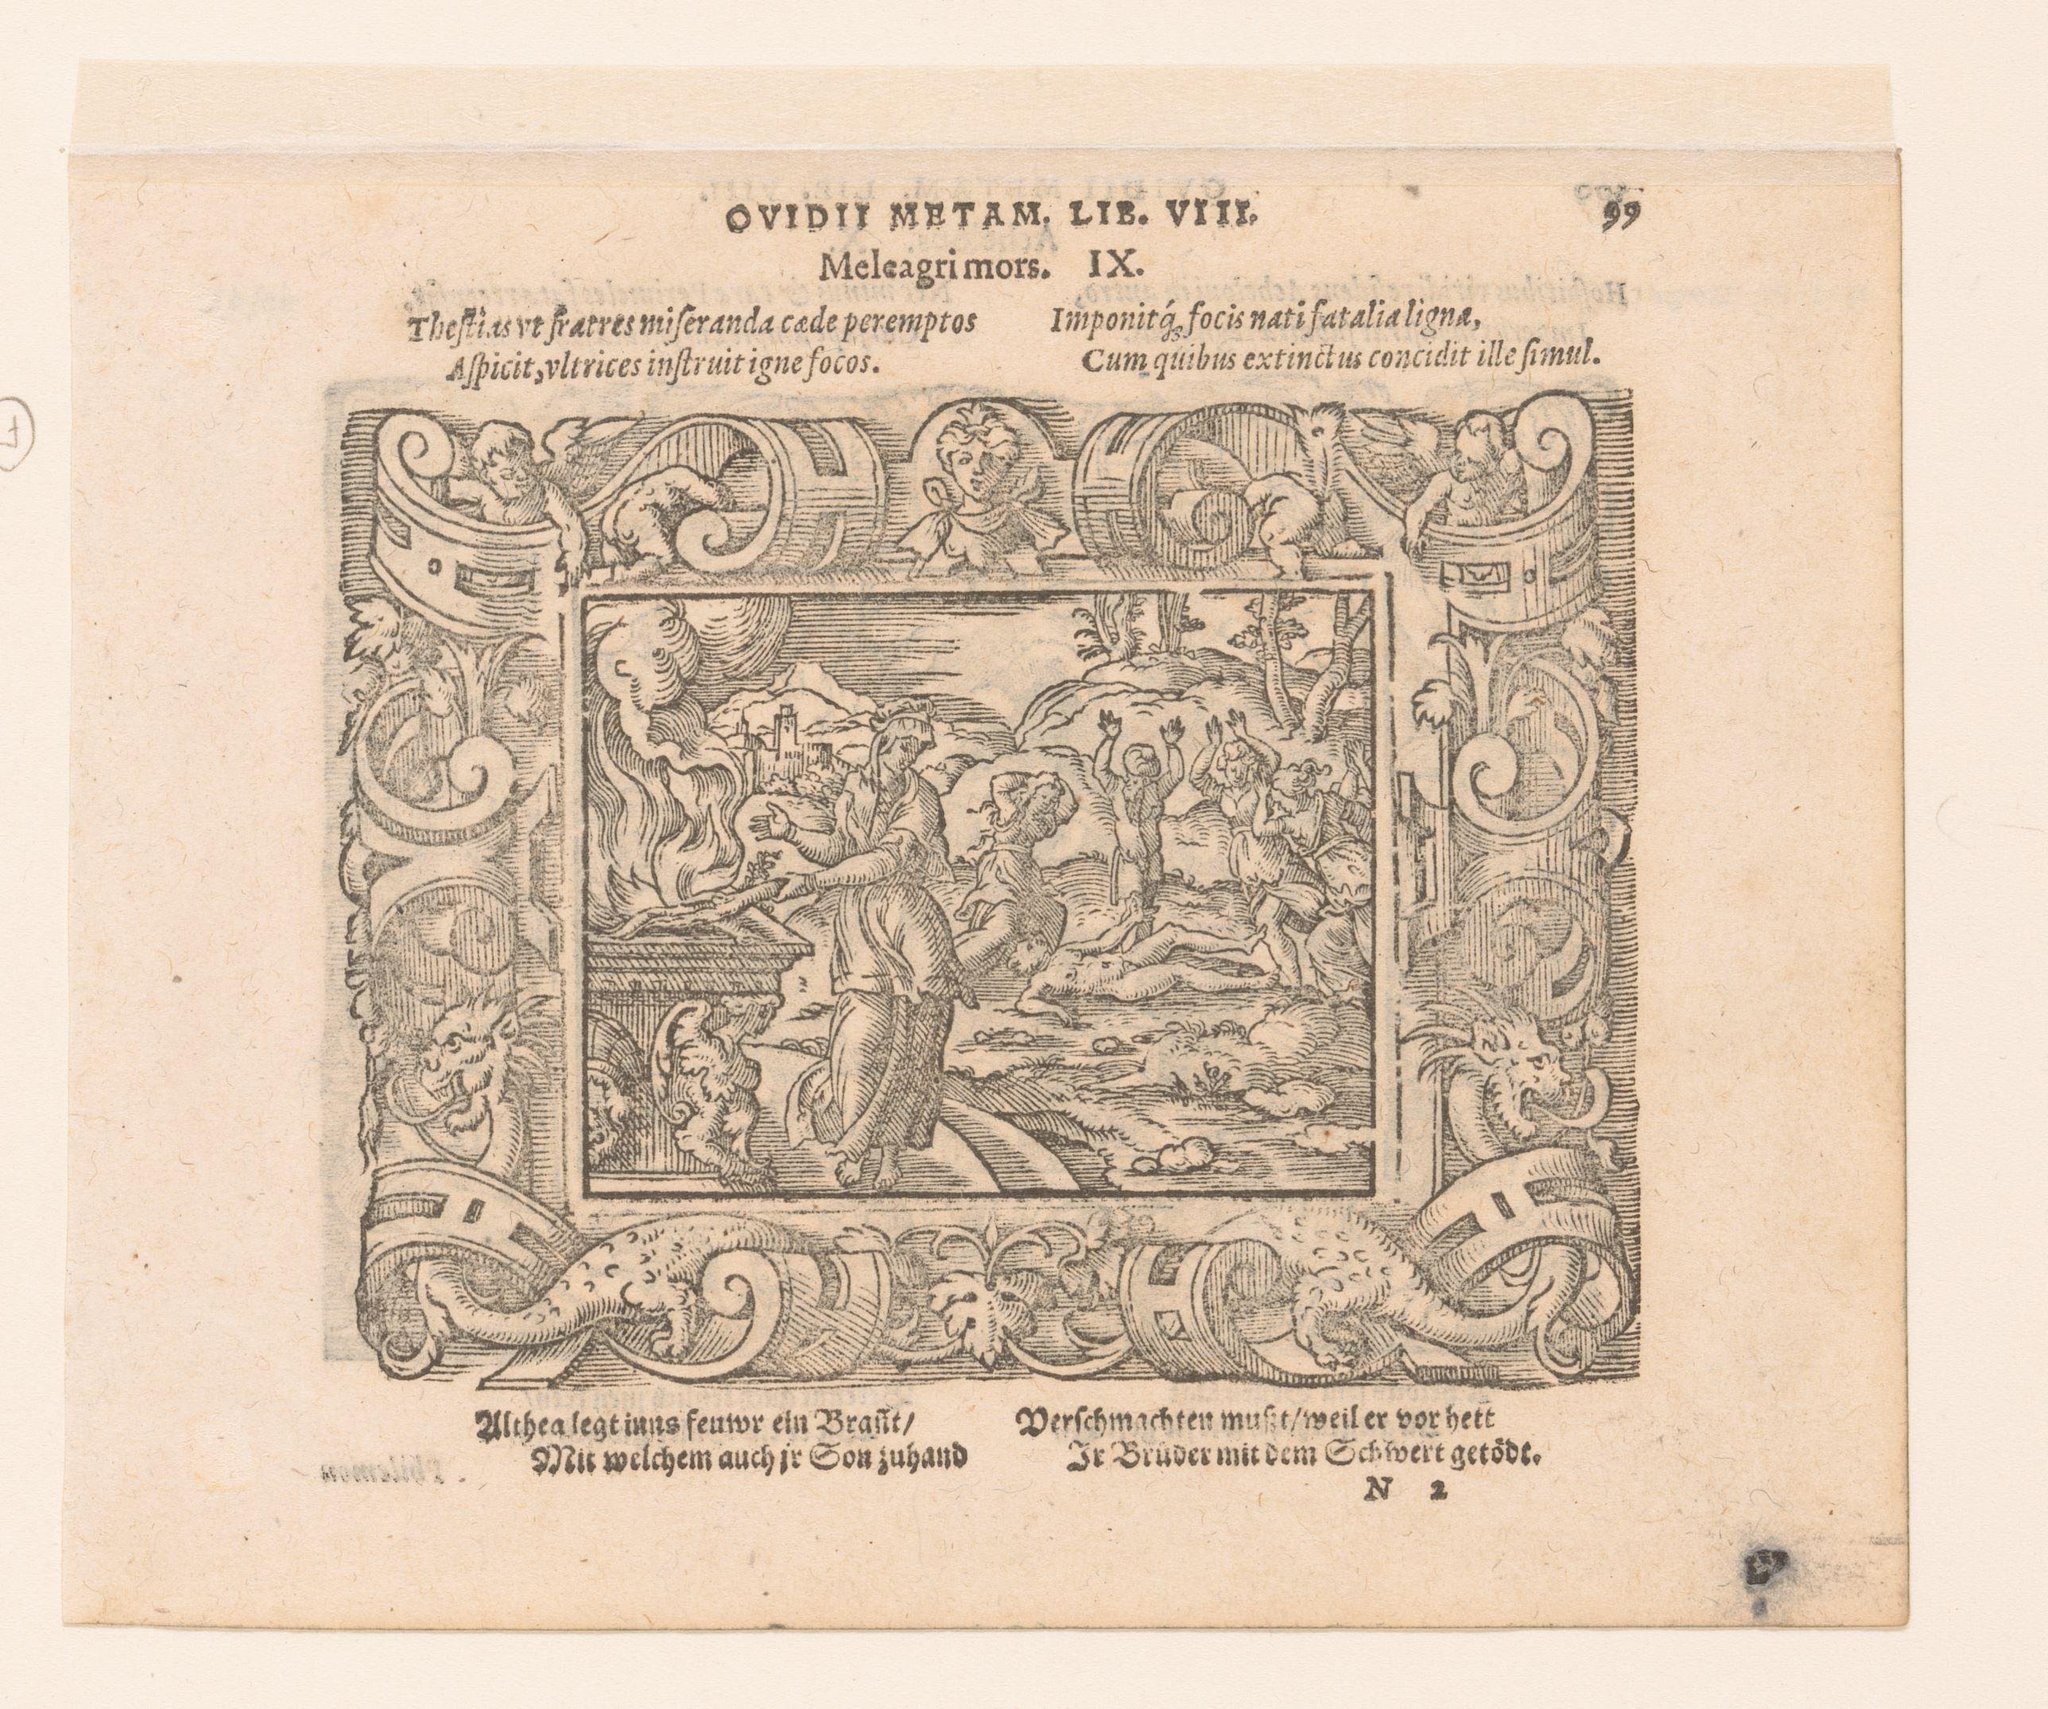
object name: book illustration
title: Dood van Meleager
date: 1569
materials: paper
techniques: letterpress printing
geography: frankfurt am main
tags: death of meleager: althaea throws the unburnt brand into the fire, thus causing meleager's death, scrollwork, strapwork ~ ornament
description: Illustratie bij de Metamorfosen van Ovidius, afkomstig uit de publicatie: Posthius, Johannes. Tetrasticha in Ovidii metam. Frankfurt am Main: Georg Rab en Sigmund Feyerabend en erven Weigand Han, 1569. De voorstellingen en ornamentranden van deze boekillustraties zijn van twee aparte blokken gedrukt. Beide werden afzonderlijk van elkaar ook gebruikt voor andere publicaties, en de ornamentranden werden eveneens binnen deze publicatie meerdere keren gebruikt.